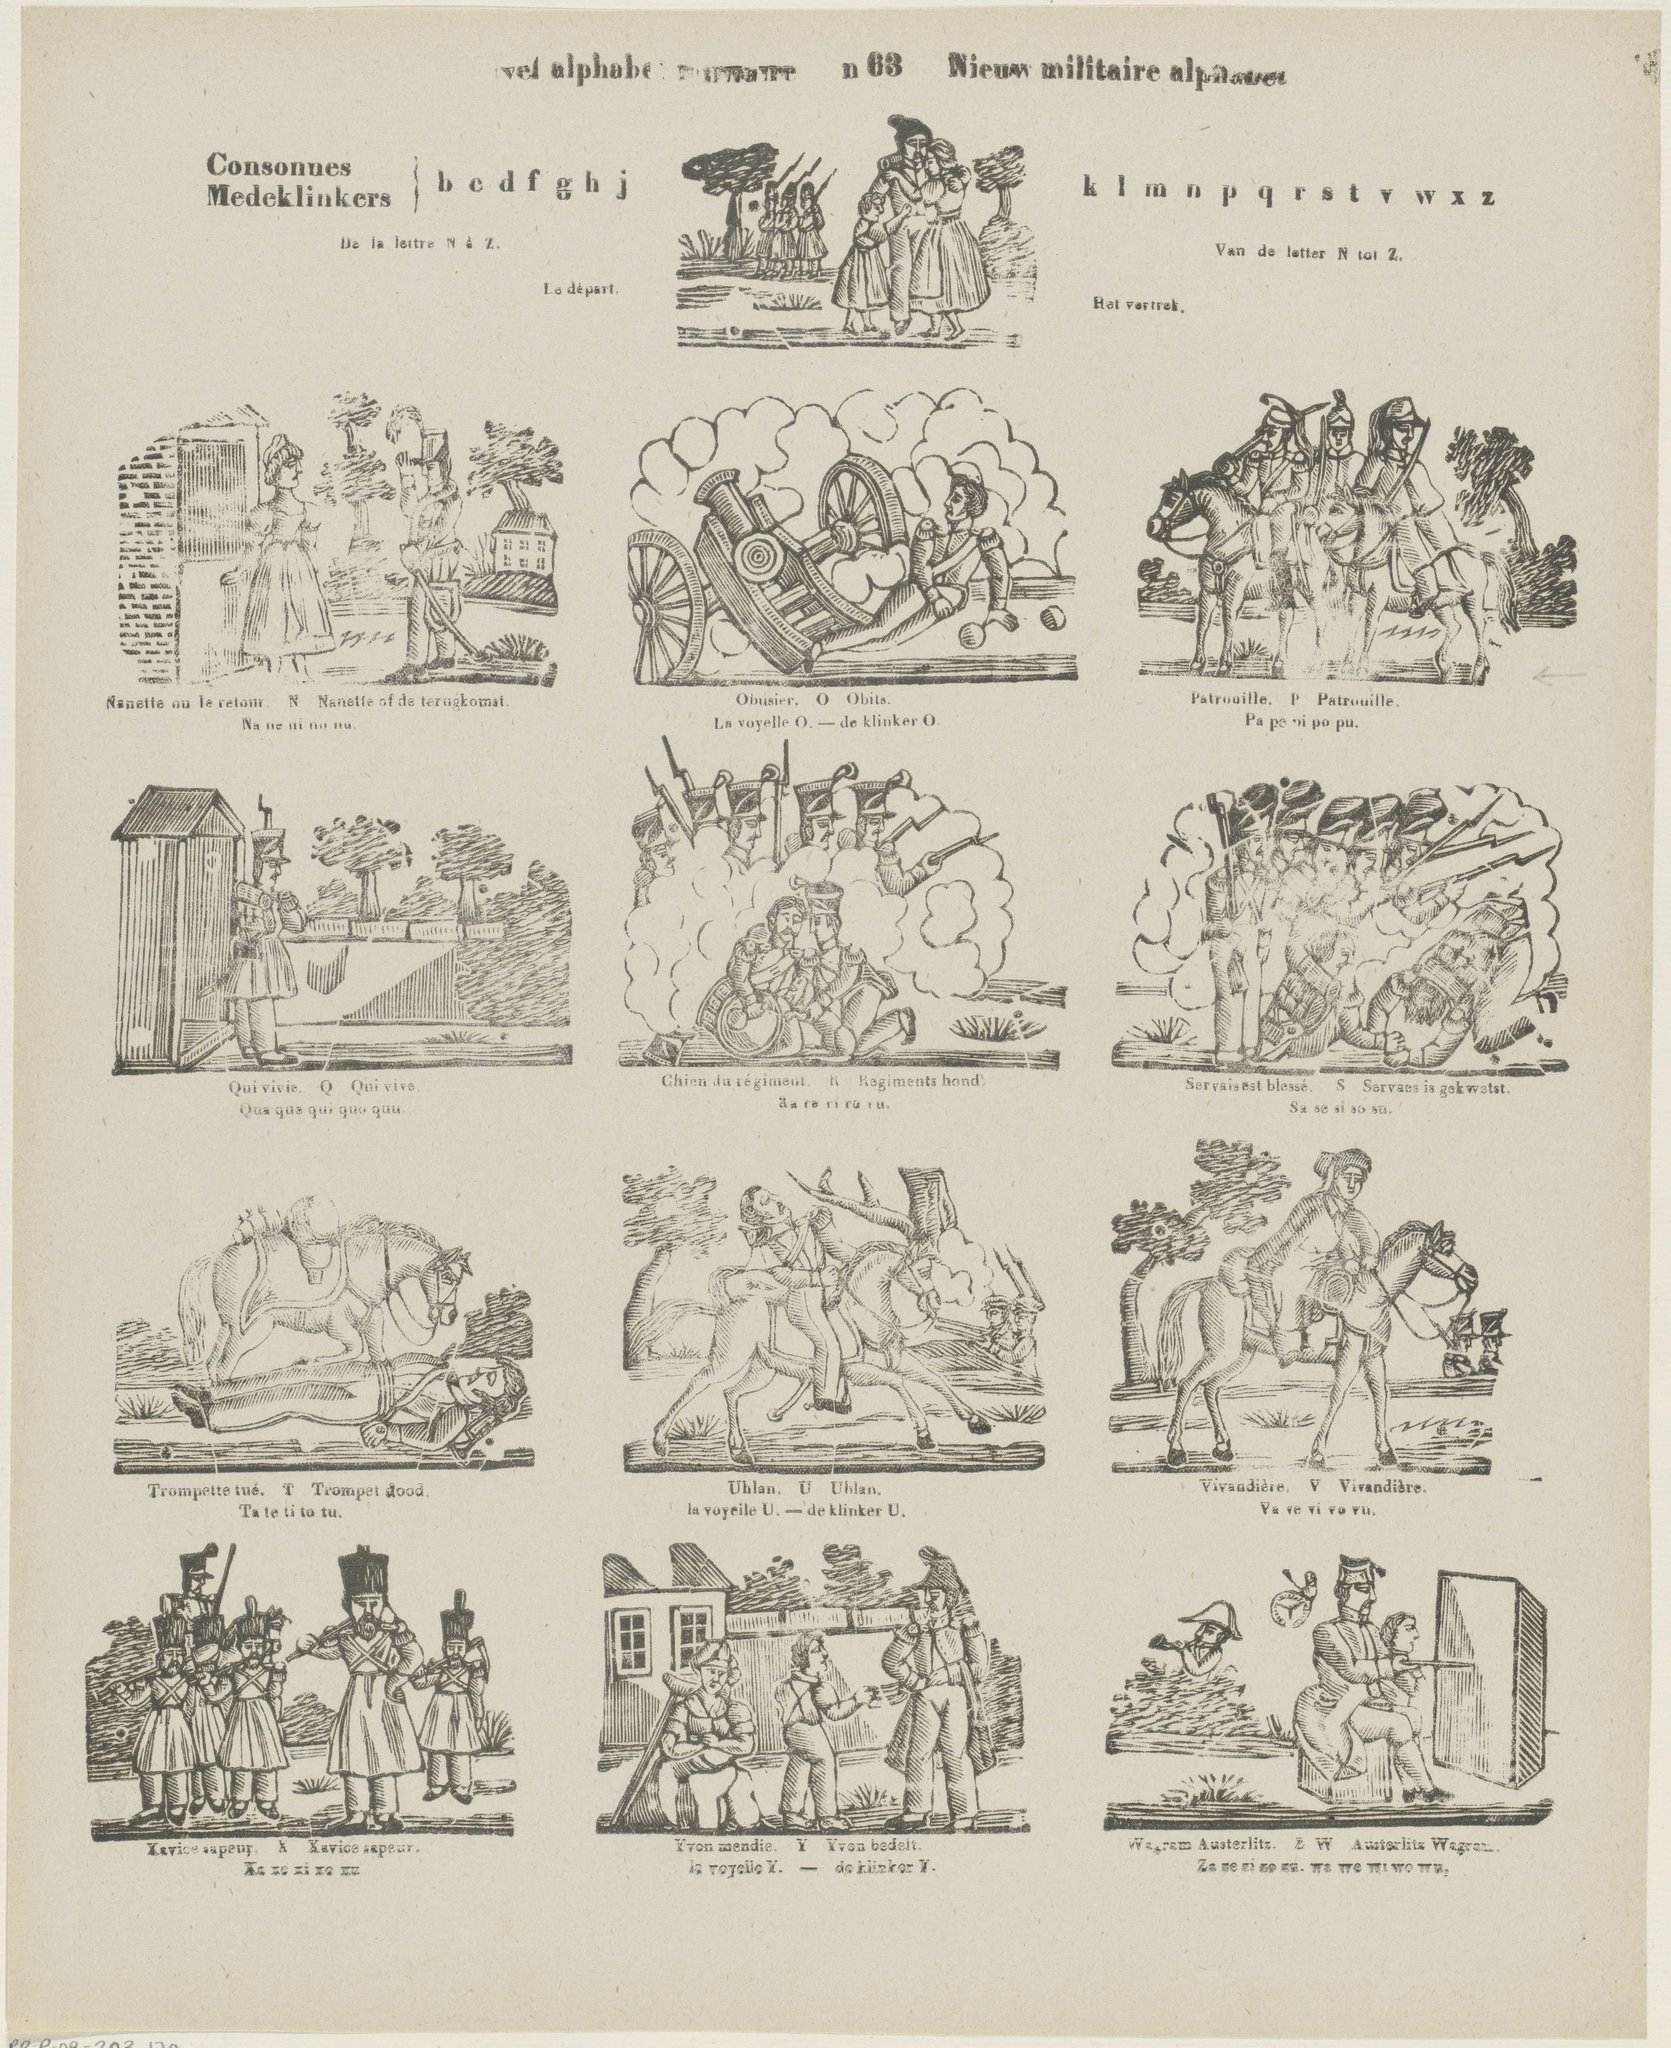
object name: popular print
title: [Nou]vel alphabet militaire / Nieuw militaire alphabet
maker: Anonymous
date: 1833-1900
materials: paper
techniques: letterpress printing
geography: netherlands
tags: letters, alphabet, script, the soldier; the soldier's life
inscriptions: collector's mark: Lugt 2760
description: Blad met 12 voorstellingen van de letters van het alfabet (N-Z) geïllustreerd met militairen waarvan de woorden met de betreffende letter beginnen. Onder elke afbeelding een onderschrift in het Nederlands en in het Frans. Genummerd midden boven: n 63.